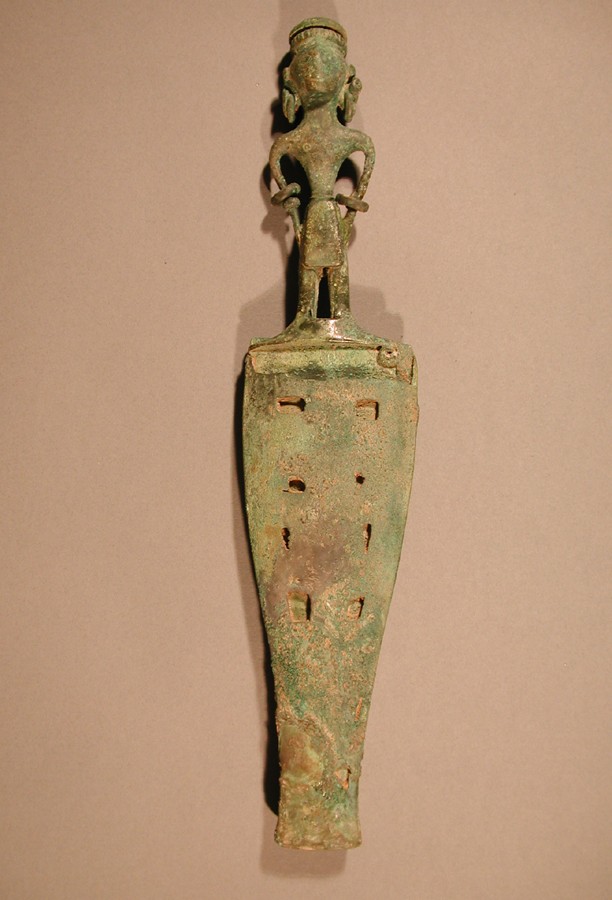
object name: dagger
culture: vietnamese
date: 500 BCE-100 CE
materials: bronze